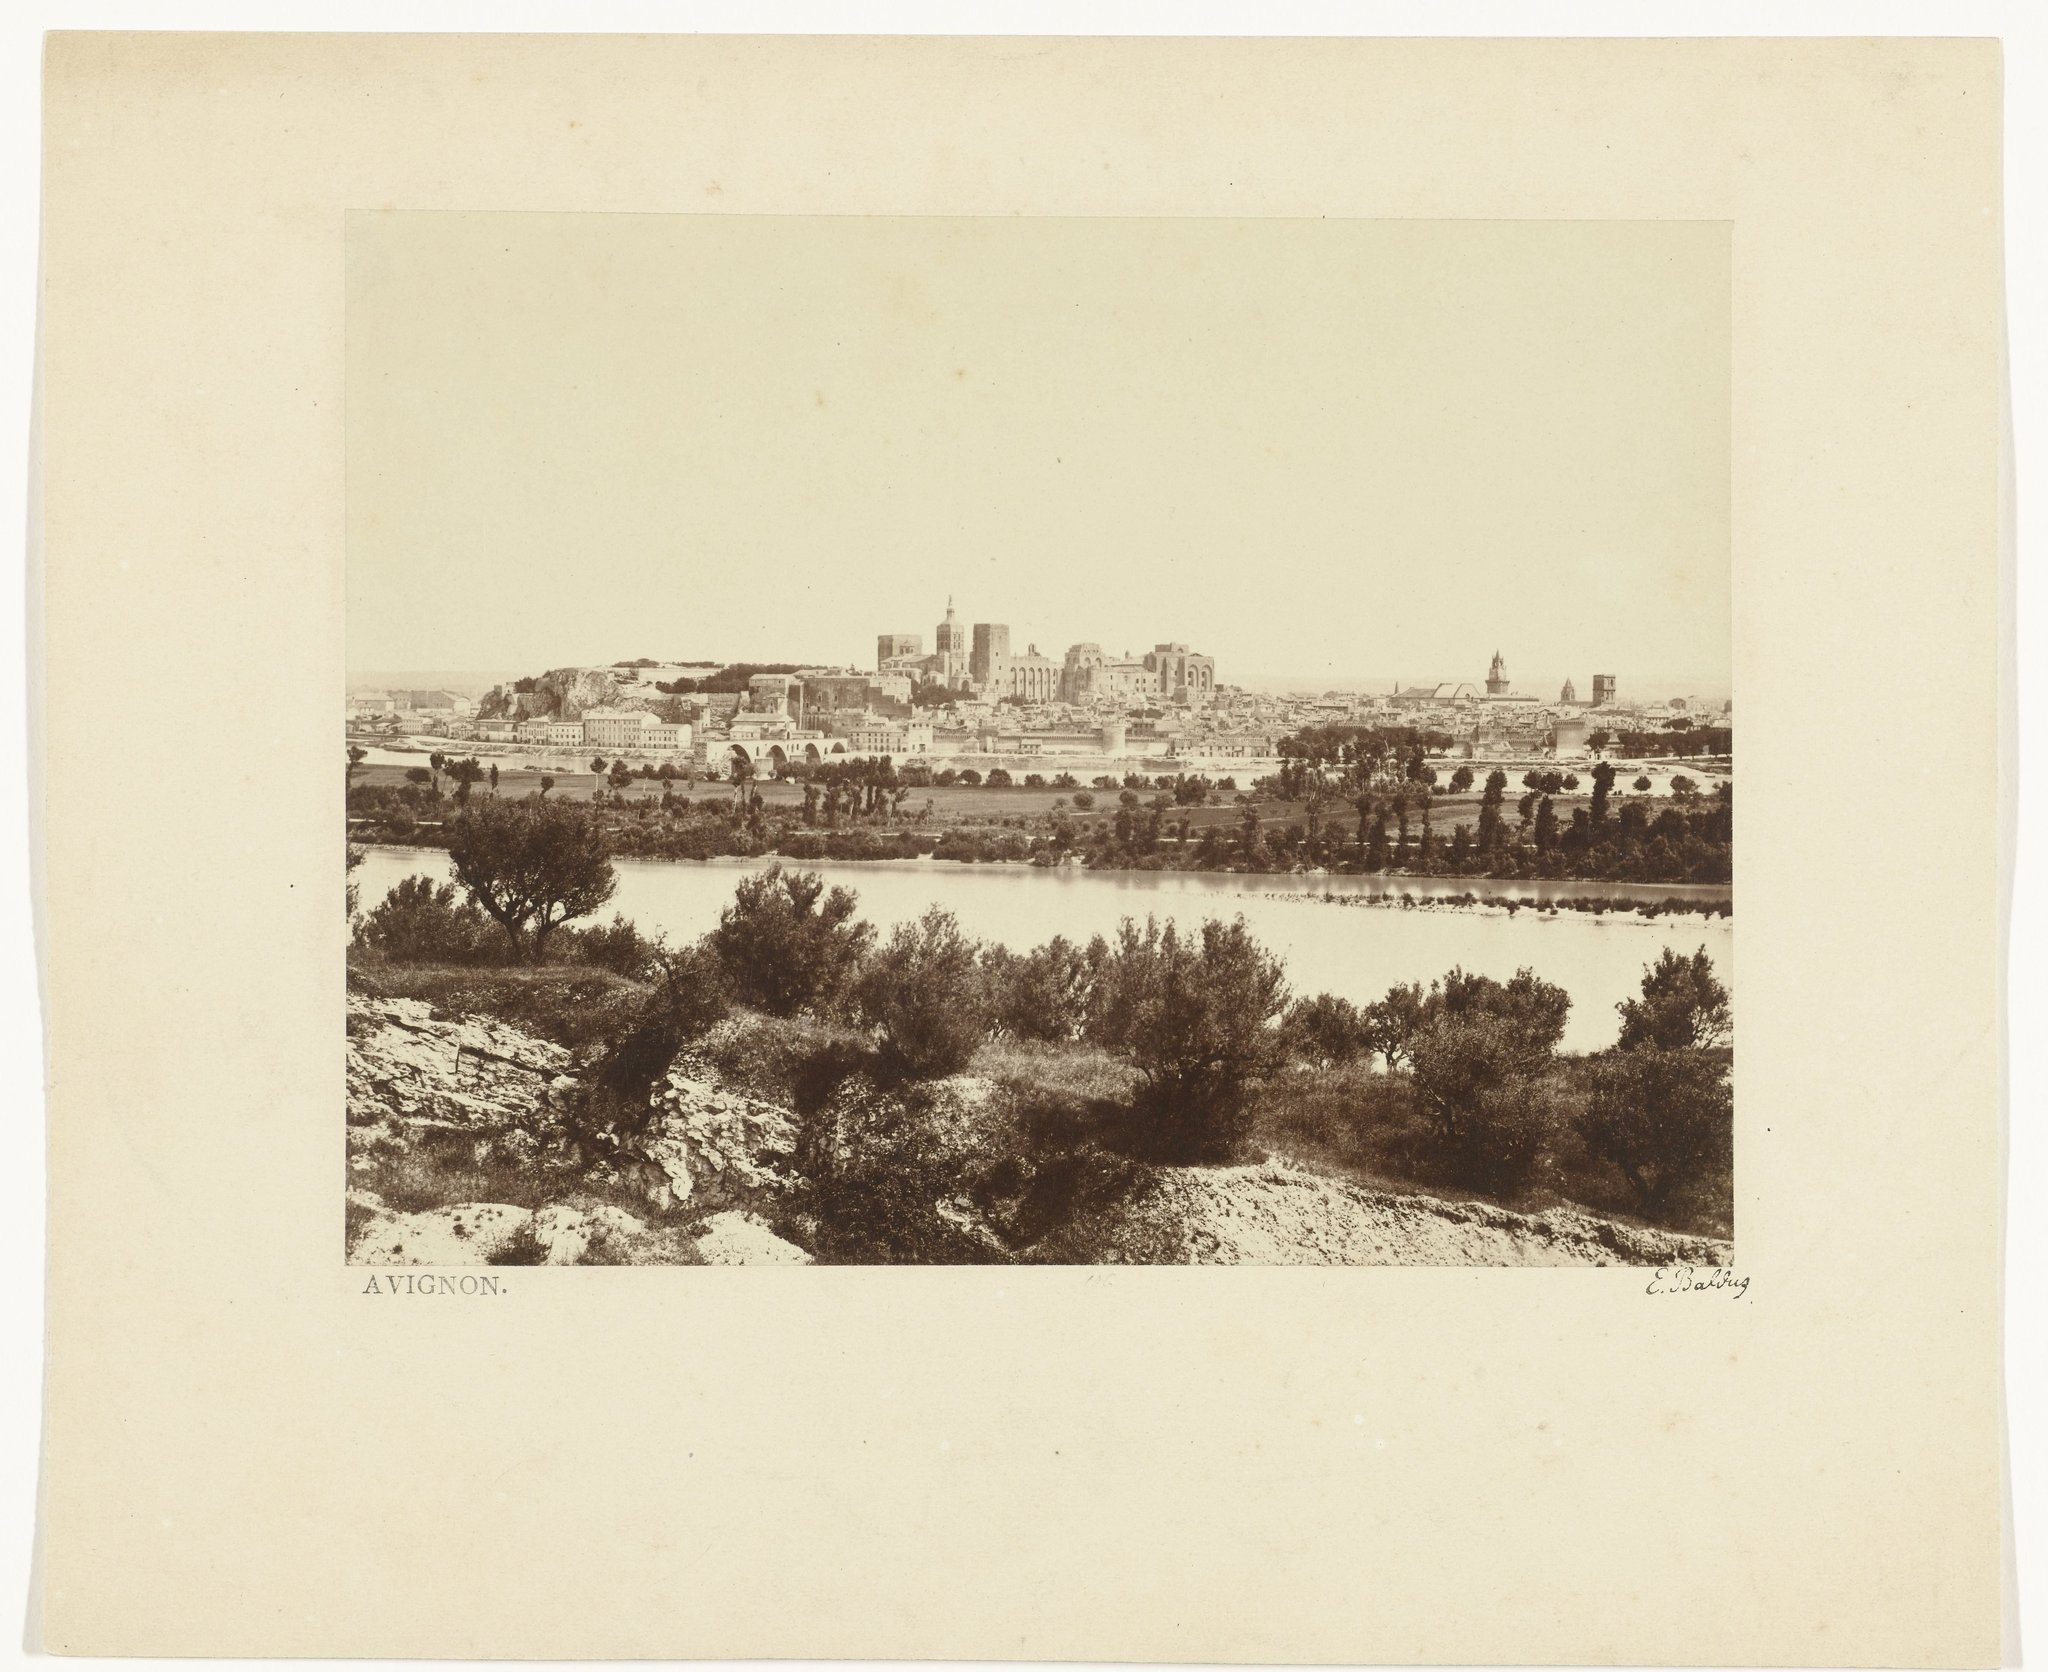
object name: photograph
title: Avignon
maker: édouard denis baldus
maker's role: fotograaf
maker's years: 1813-1889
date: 1856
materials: cardboard, paper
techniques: albumen print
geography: avignon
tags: city-view in general; 'veduta', river